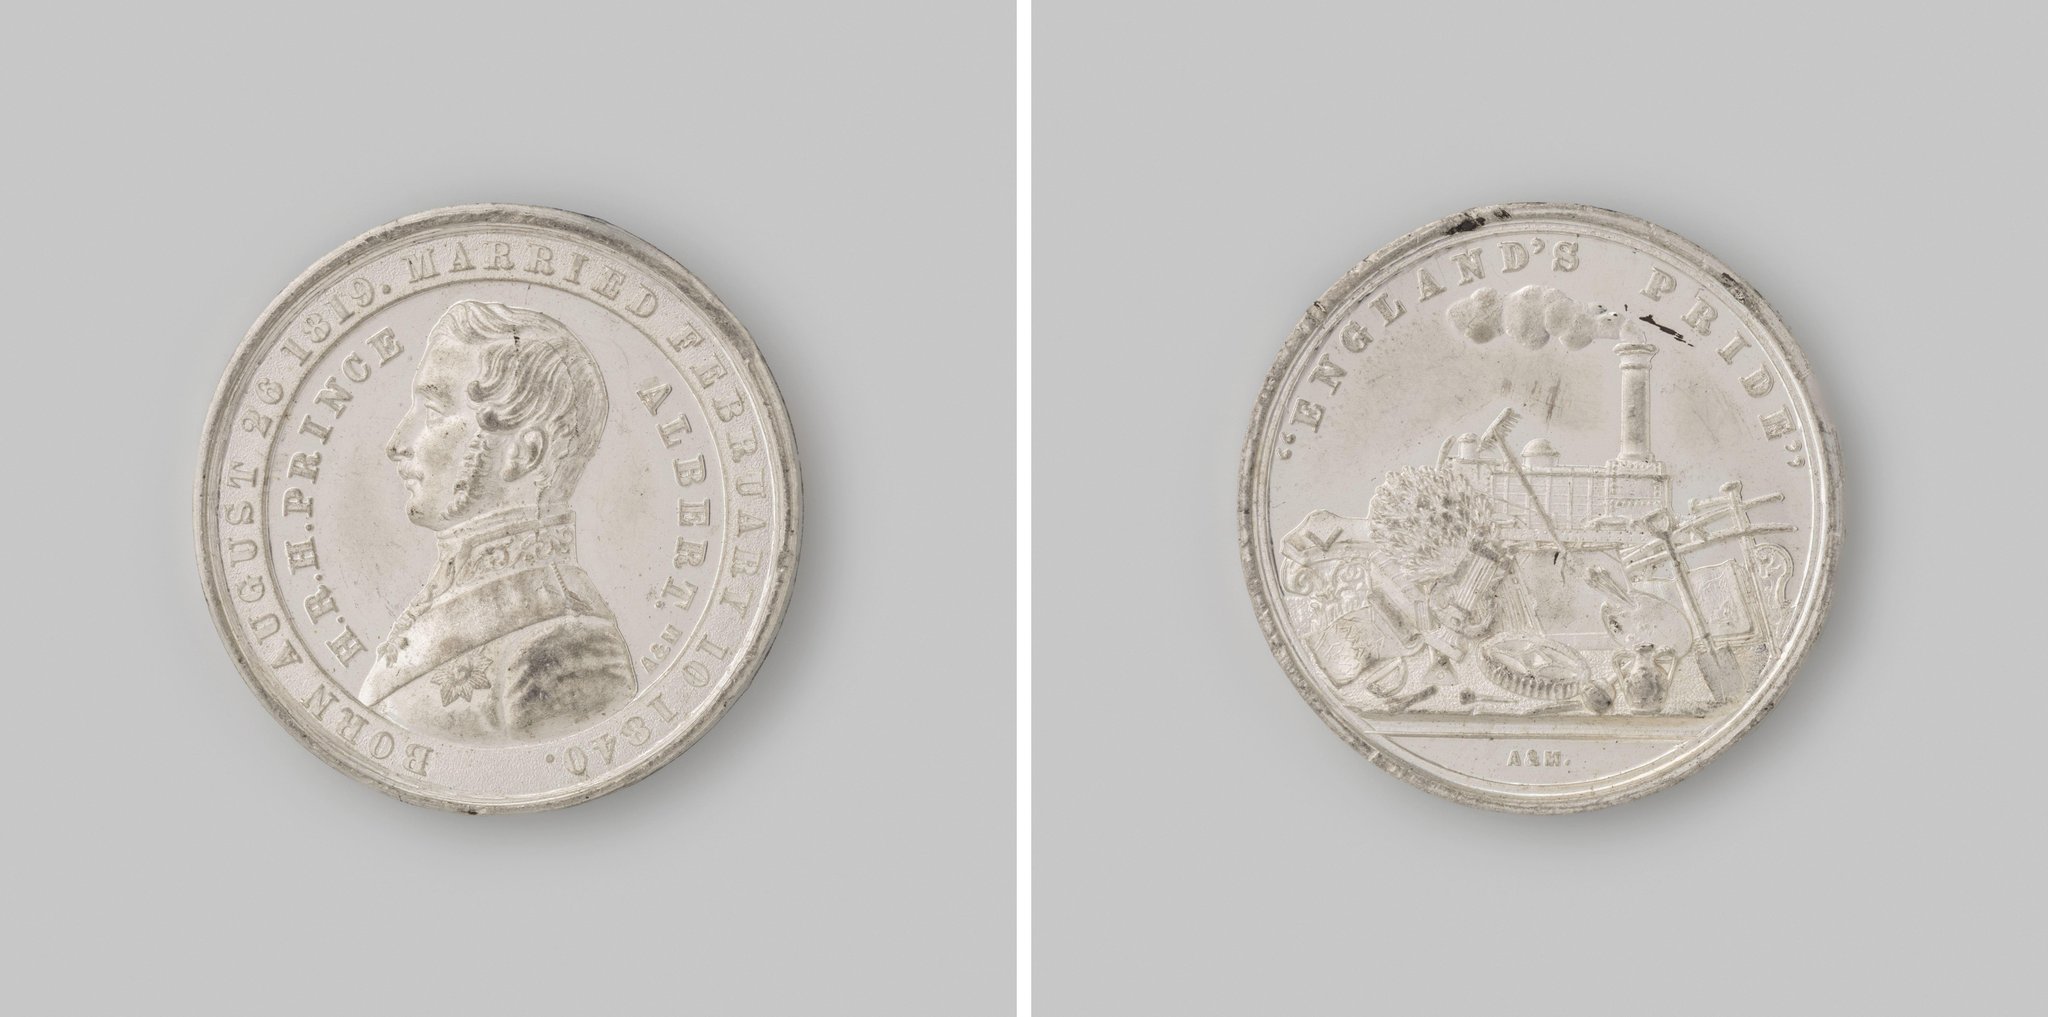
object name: history medal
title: Huwelijk van Koningin Victoria van Engeland met Albert van Saksen Coburg Gotha 1840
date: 1840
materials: tin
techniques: striking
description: Tinnen penning, op de voorzijde het borstbeeld van Albert naar links met dubbel omschrift, op de keerzijde symbolen van landbouw en industrie, met omschrift.